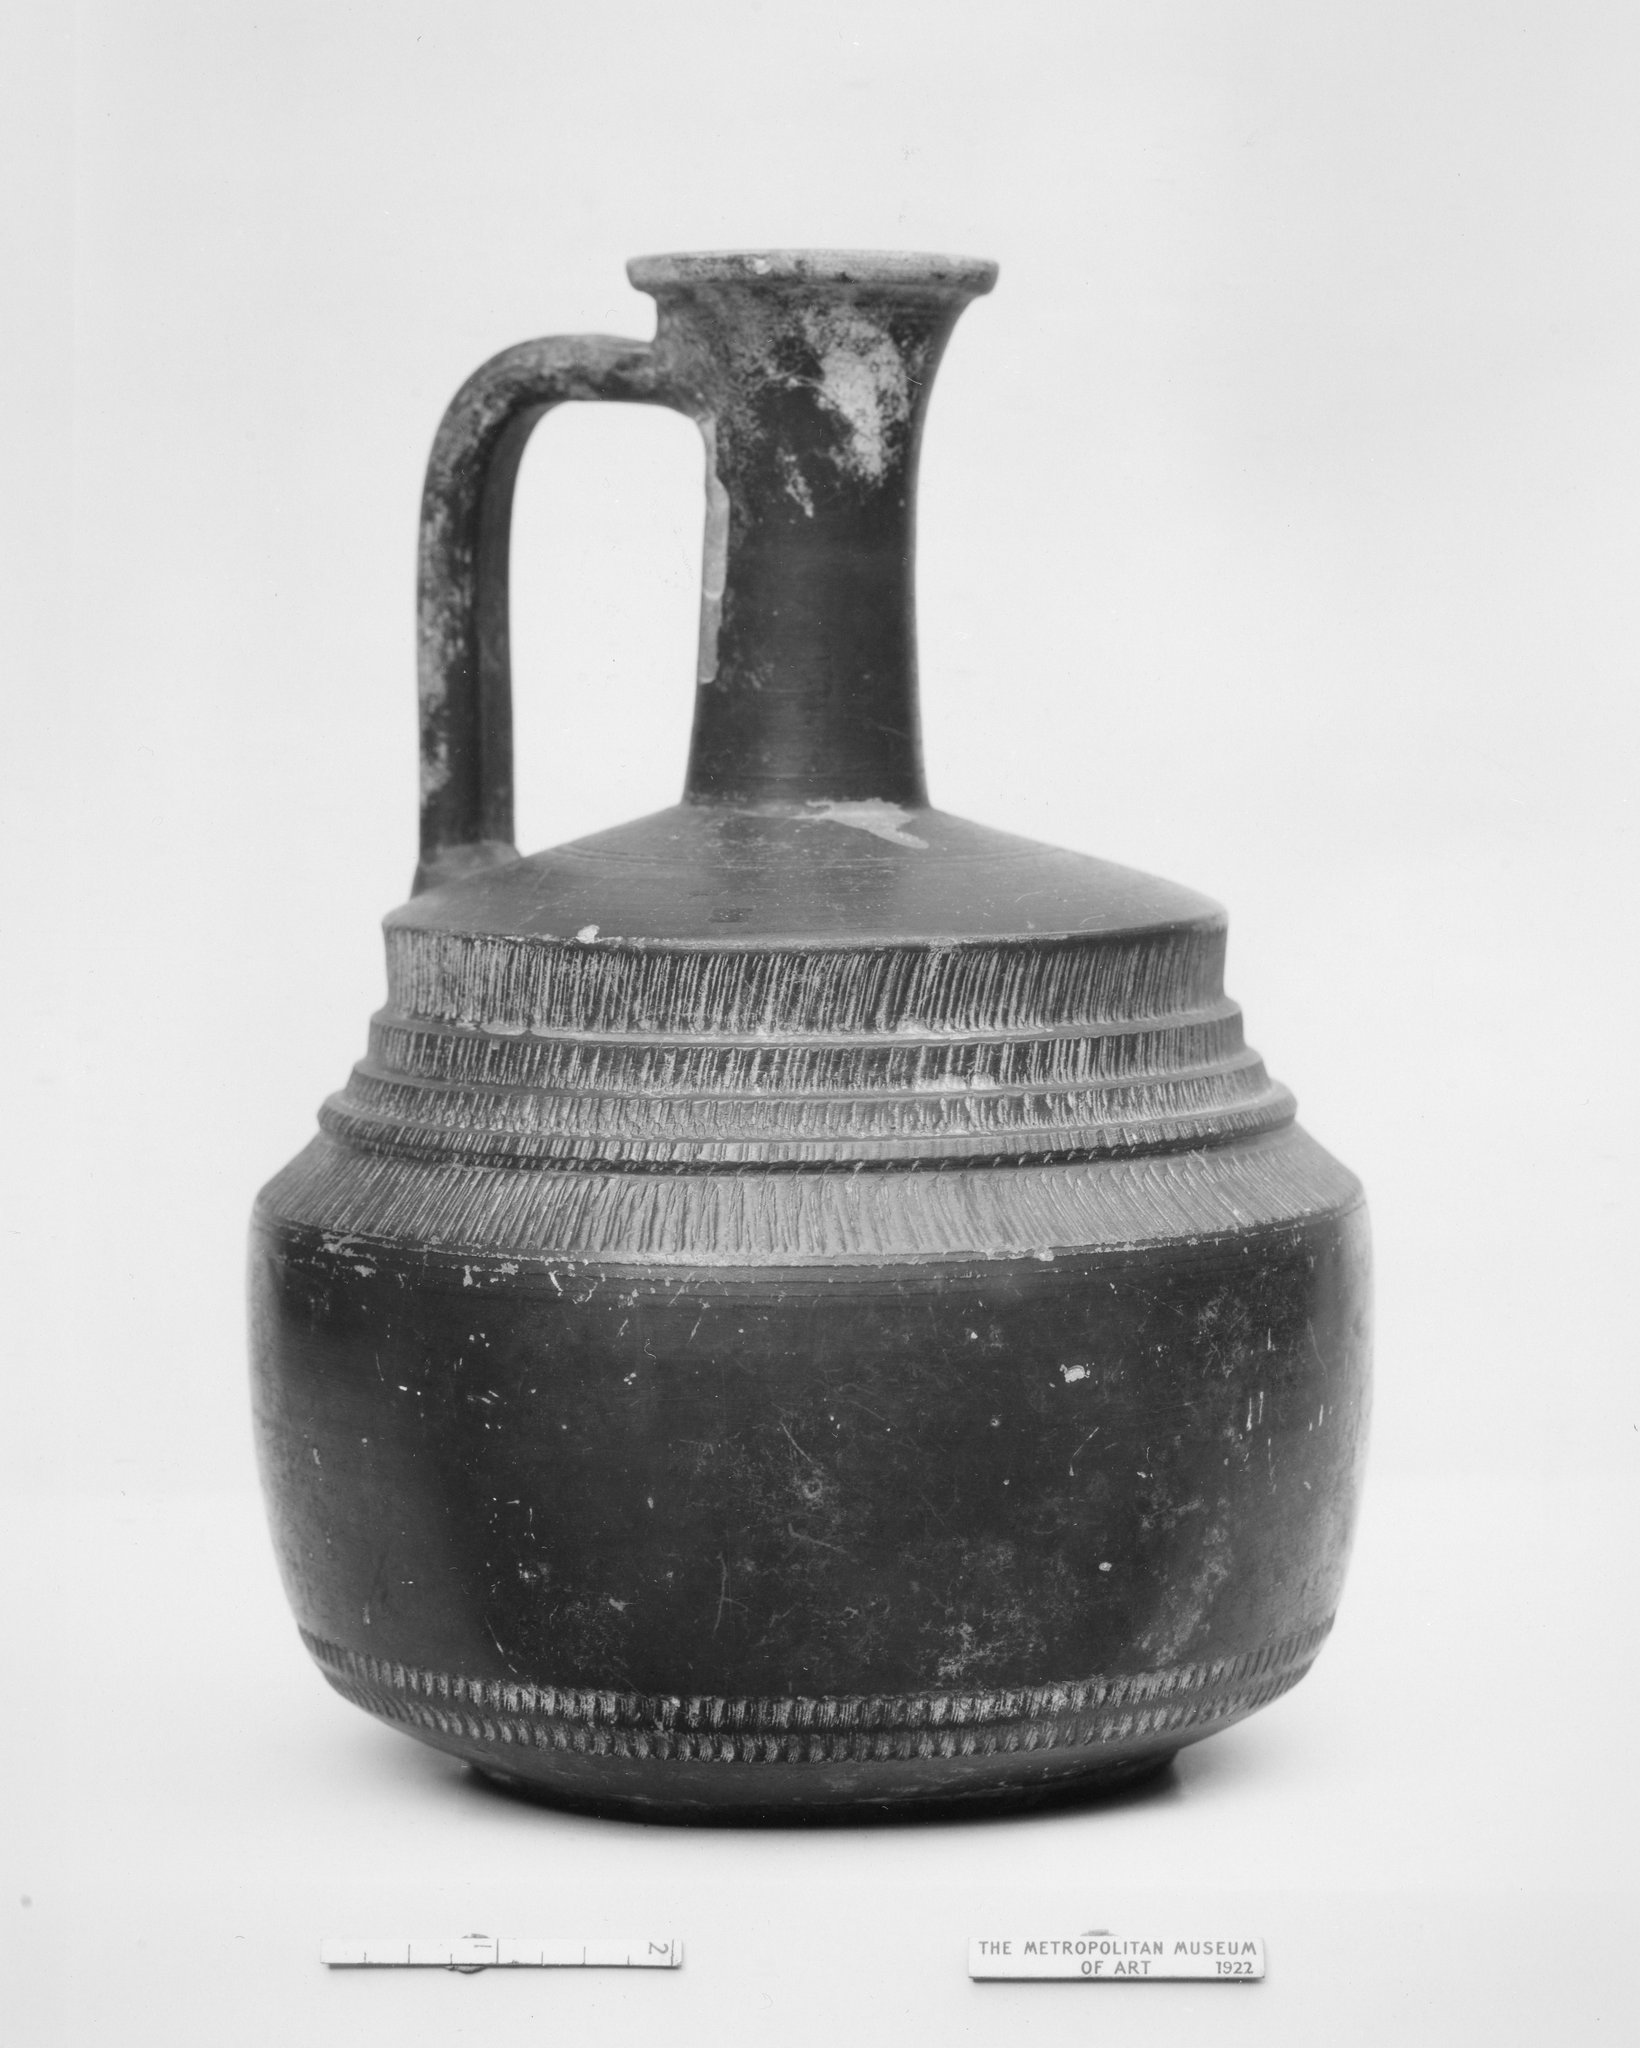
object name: jug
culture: roman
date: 1-300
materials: terracotta